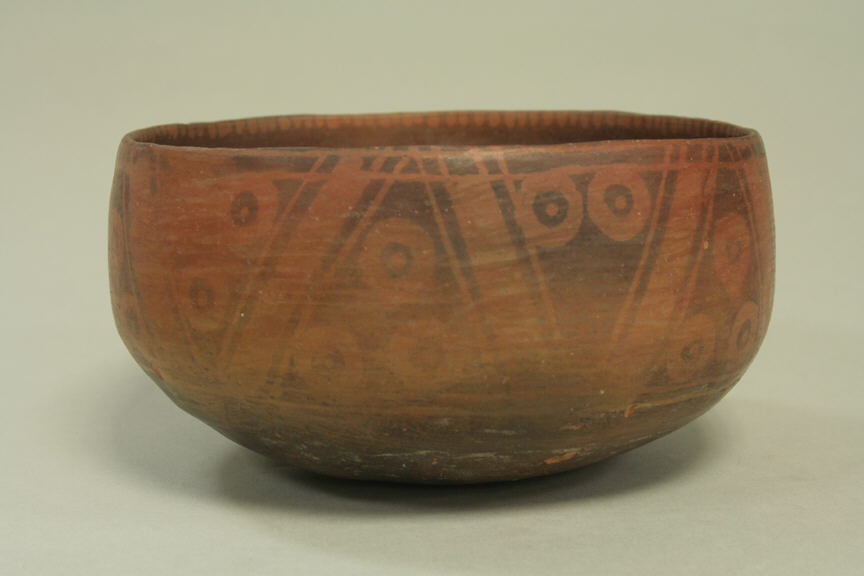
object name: bowl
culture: paracas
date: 300-101 BCE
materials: ceramic, pigment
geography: peru